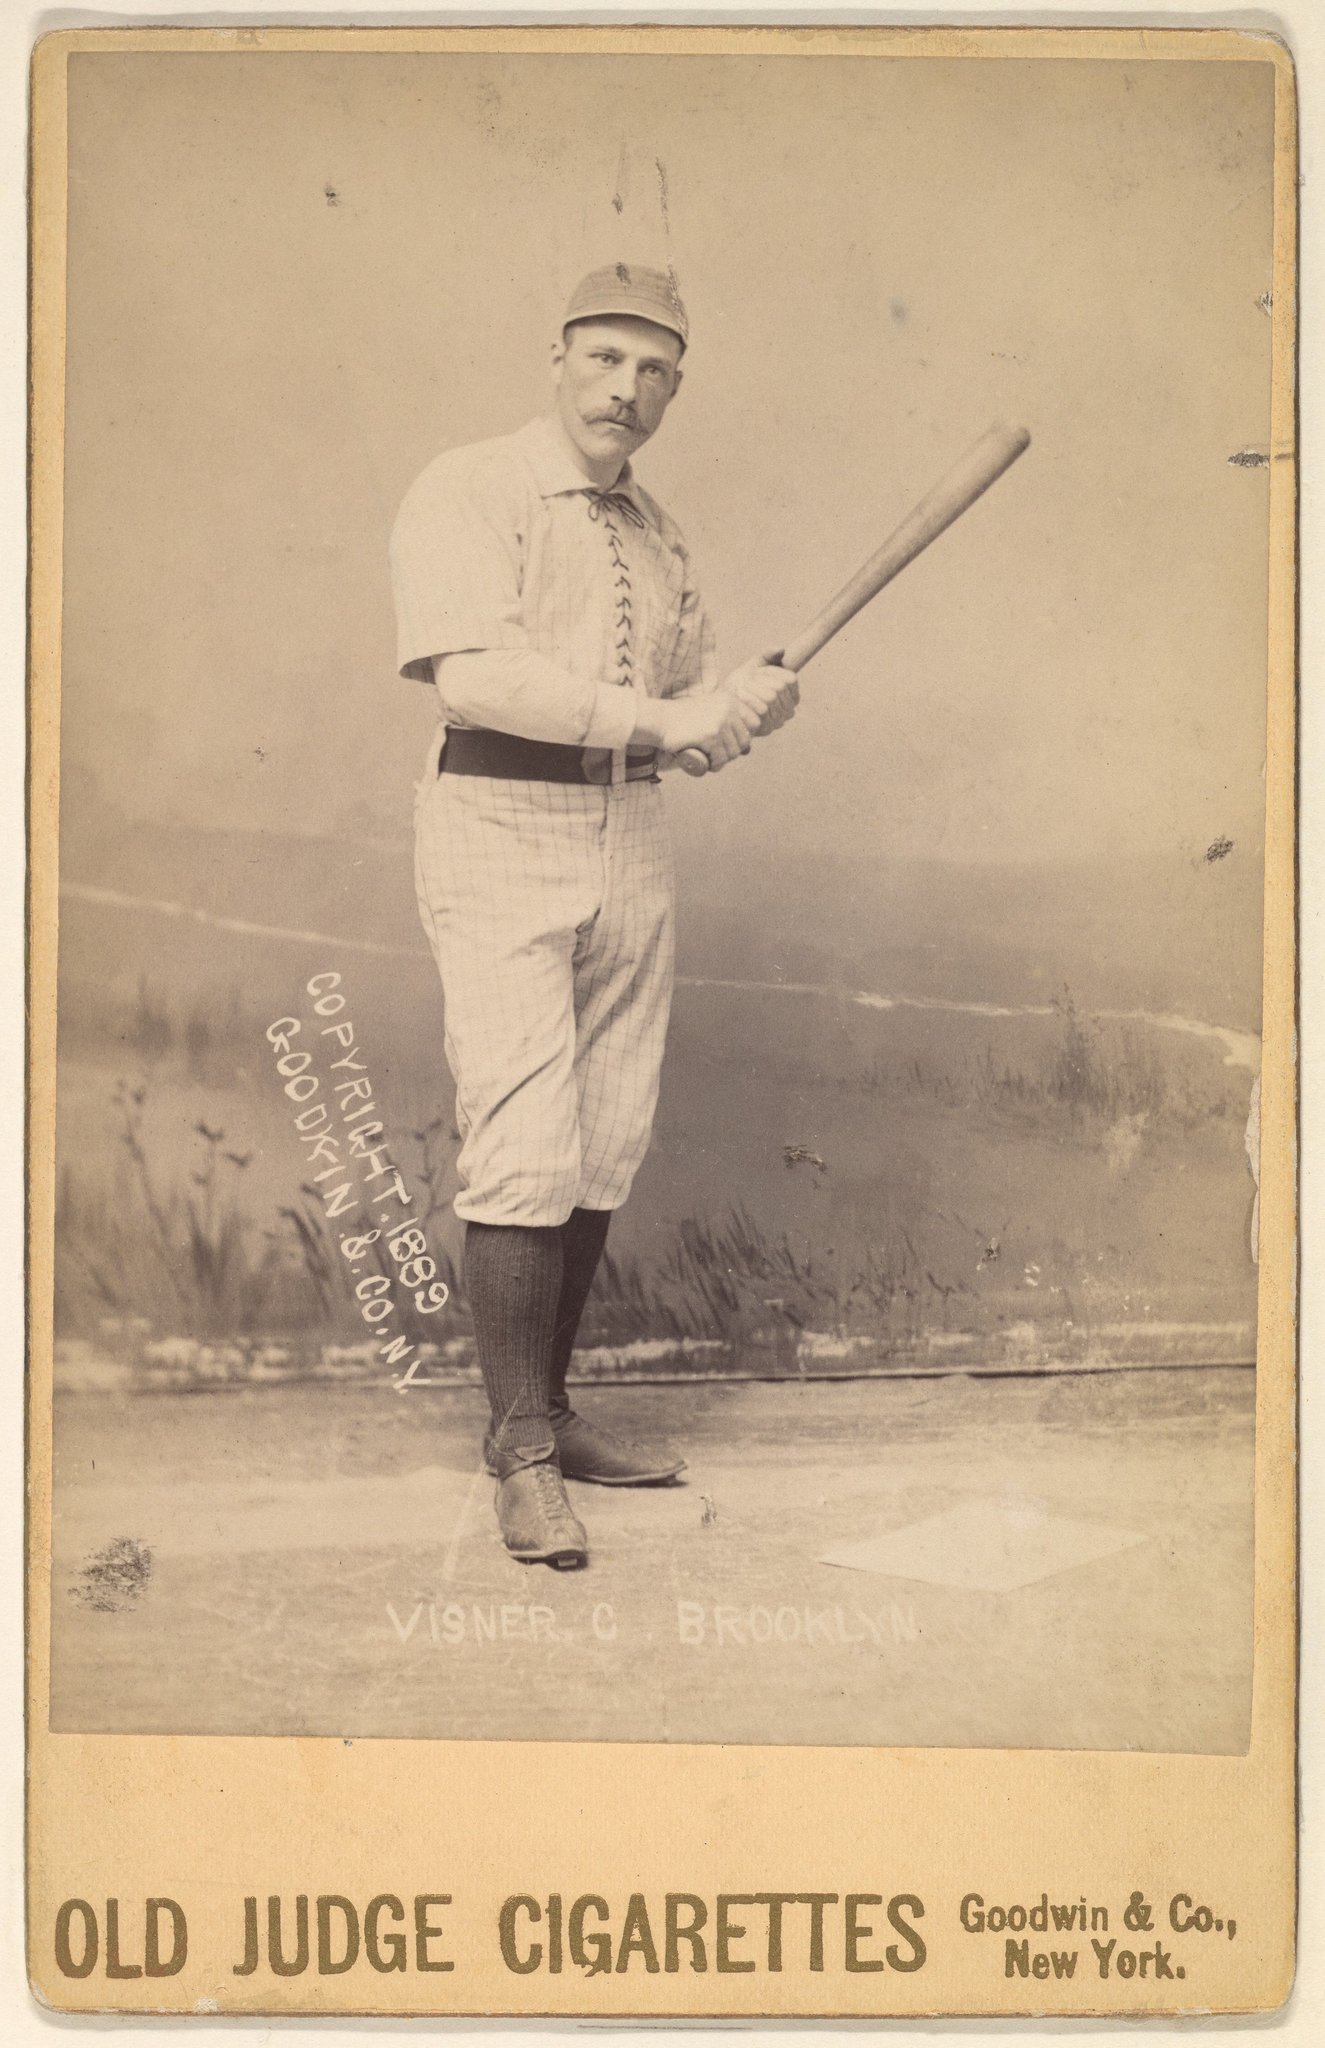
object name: baseball card, photograph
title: Joseph Paul Visner, Catcher, Brooklyn, from the series Old Judge Cigarettes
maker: goodwin & company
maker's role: publisher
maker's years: 1850-1950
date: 1889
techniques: albumen silver print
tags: men,portraits,baseball,athletes